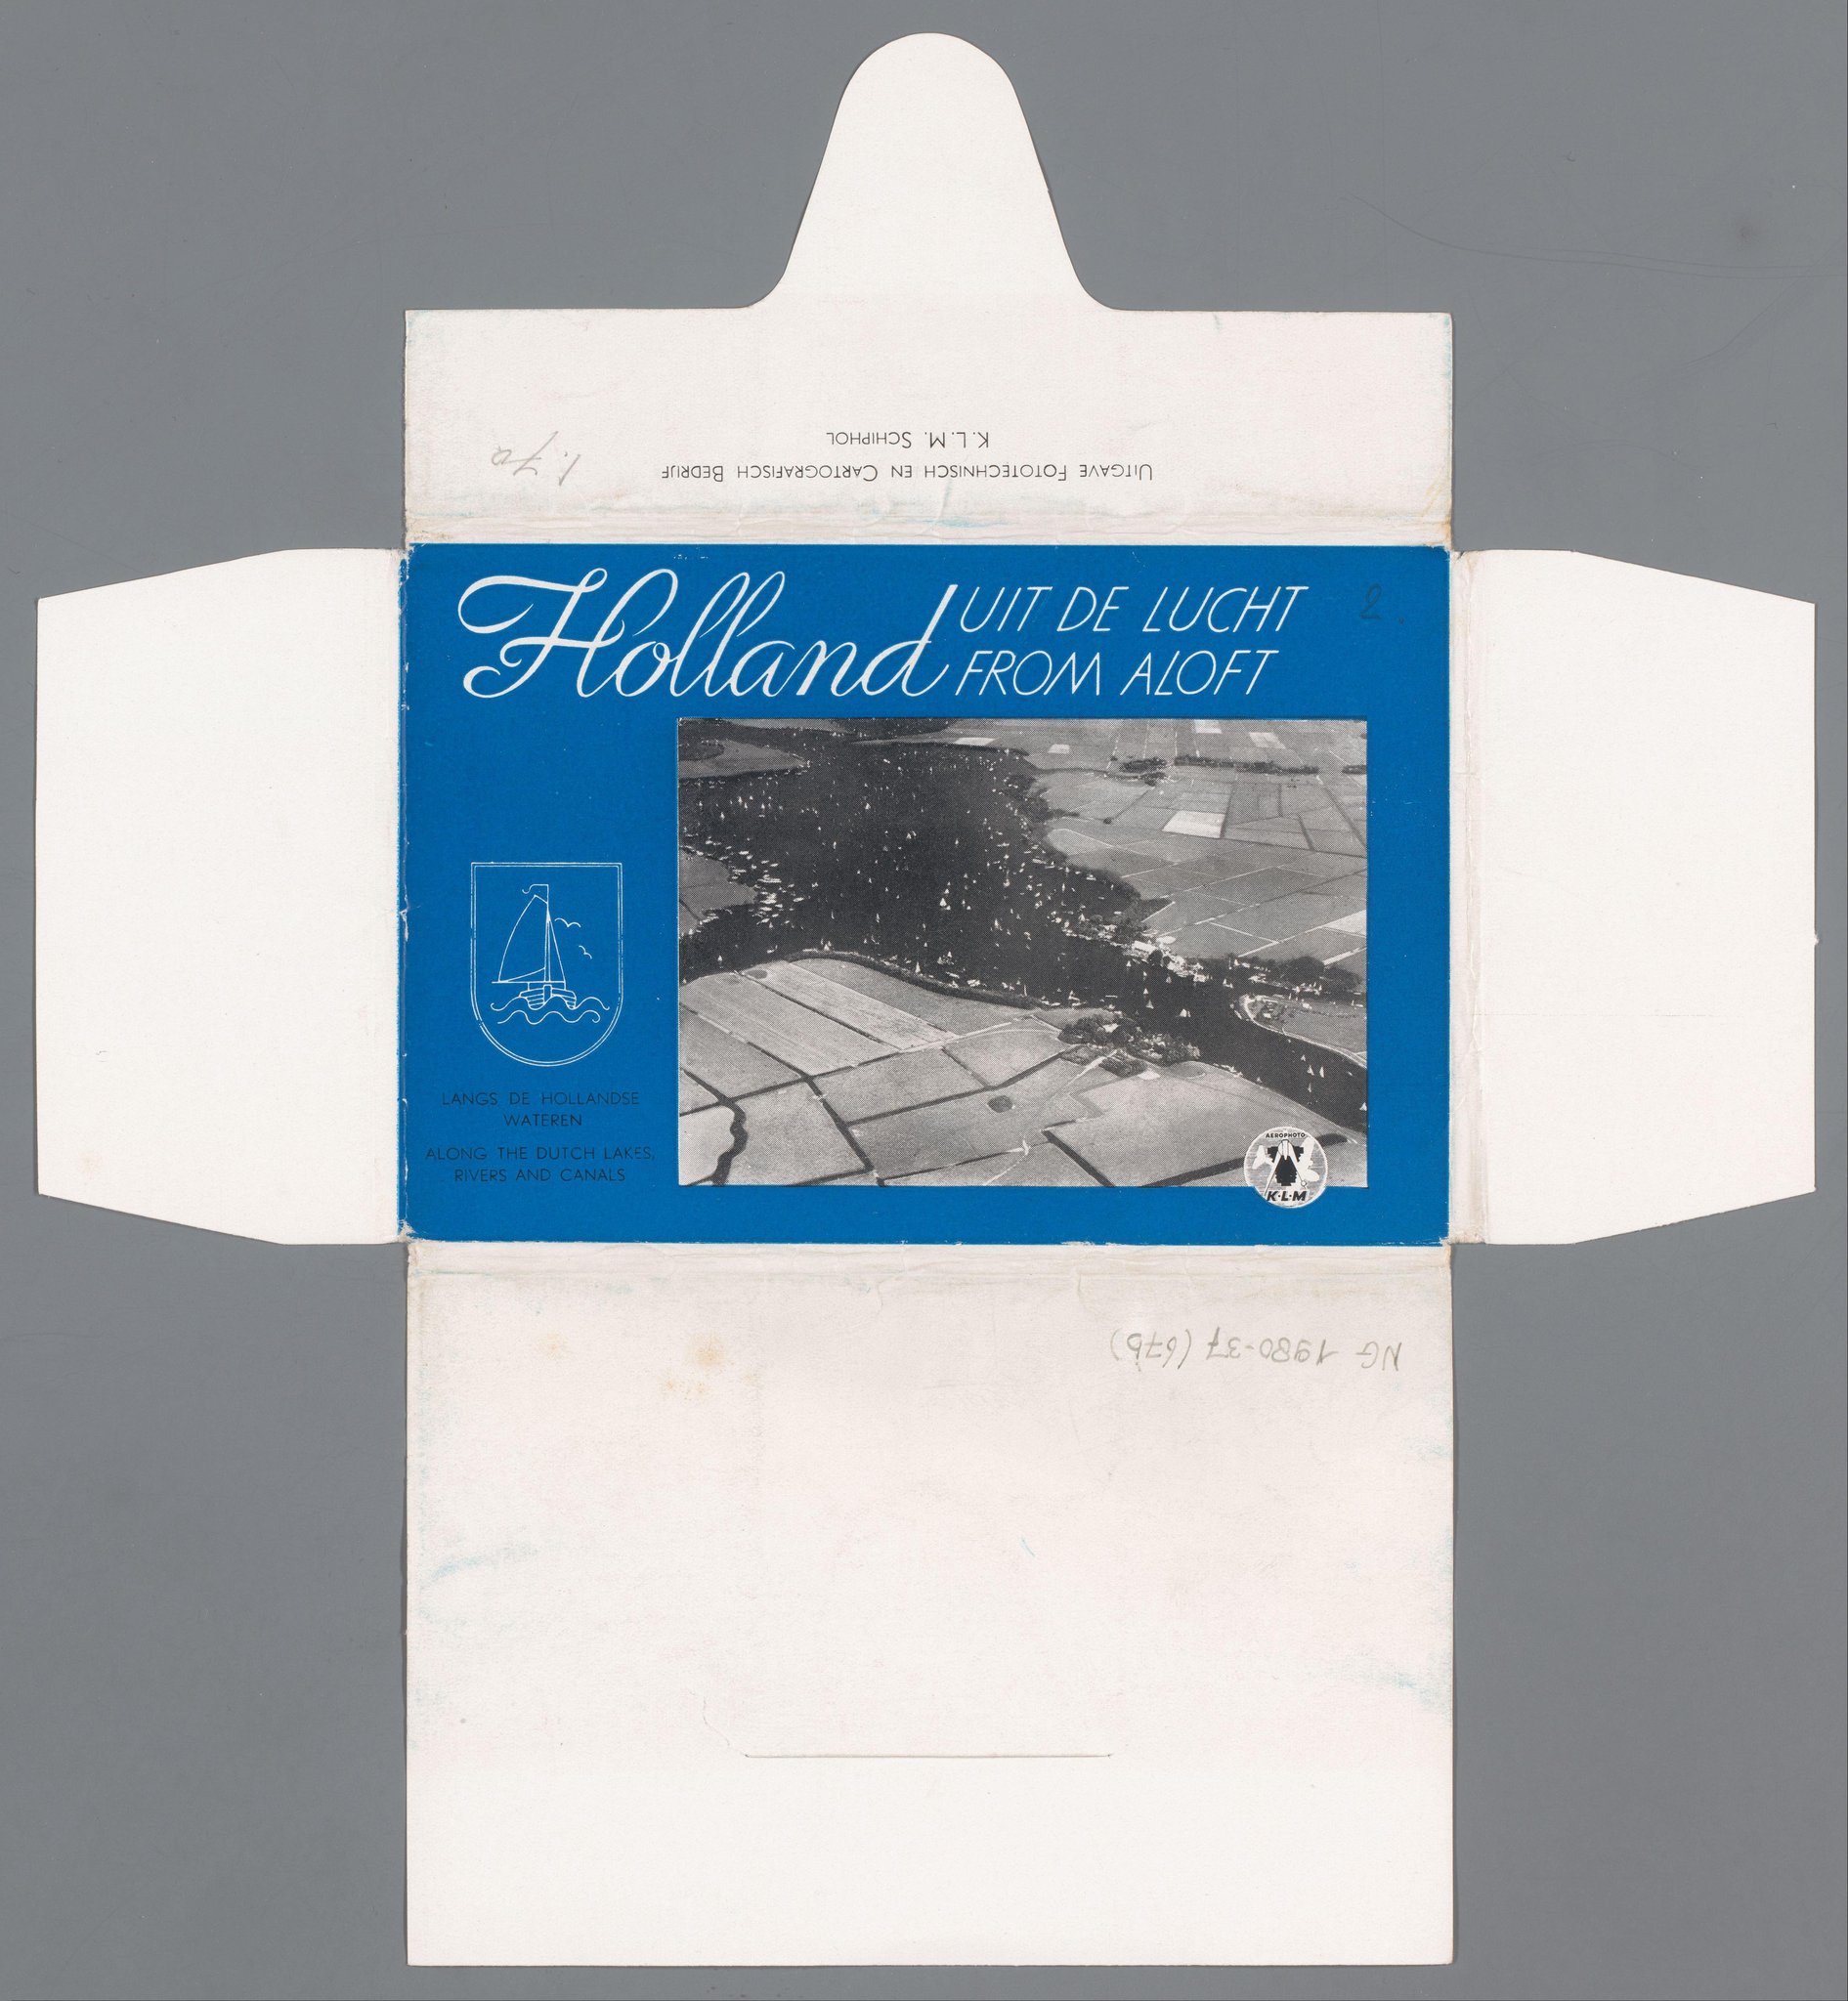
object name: postcard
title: Holland uit de lucht. Langs de Hollandse wateren.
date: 1950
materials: paper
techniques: photography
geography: amsterdam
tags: netherlands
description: Mapje met 7 zwart-wit luchtfotos, plassen en rivieren, de zee, uitgevoerd als briefkaarten.